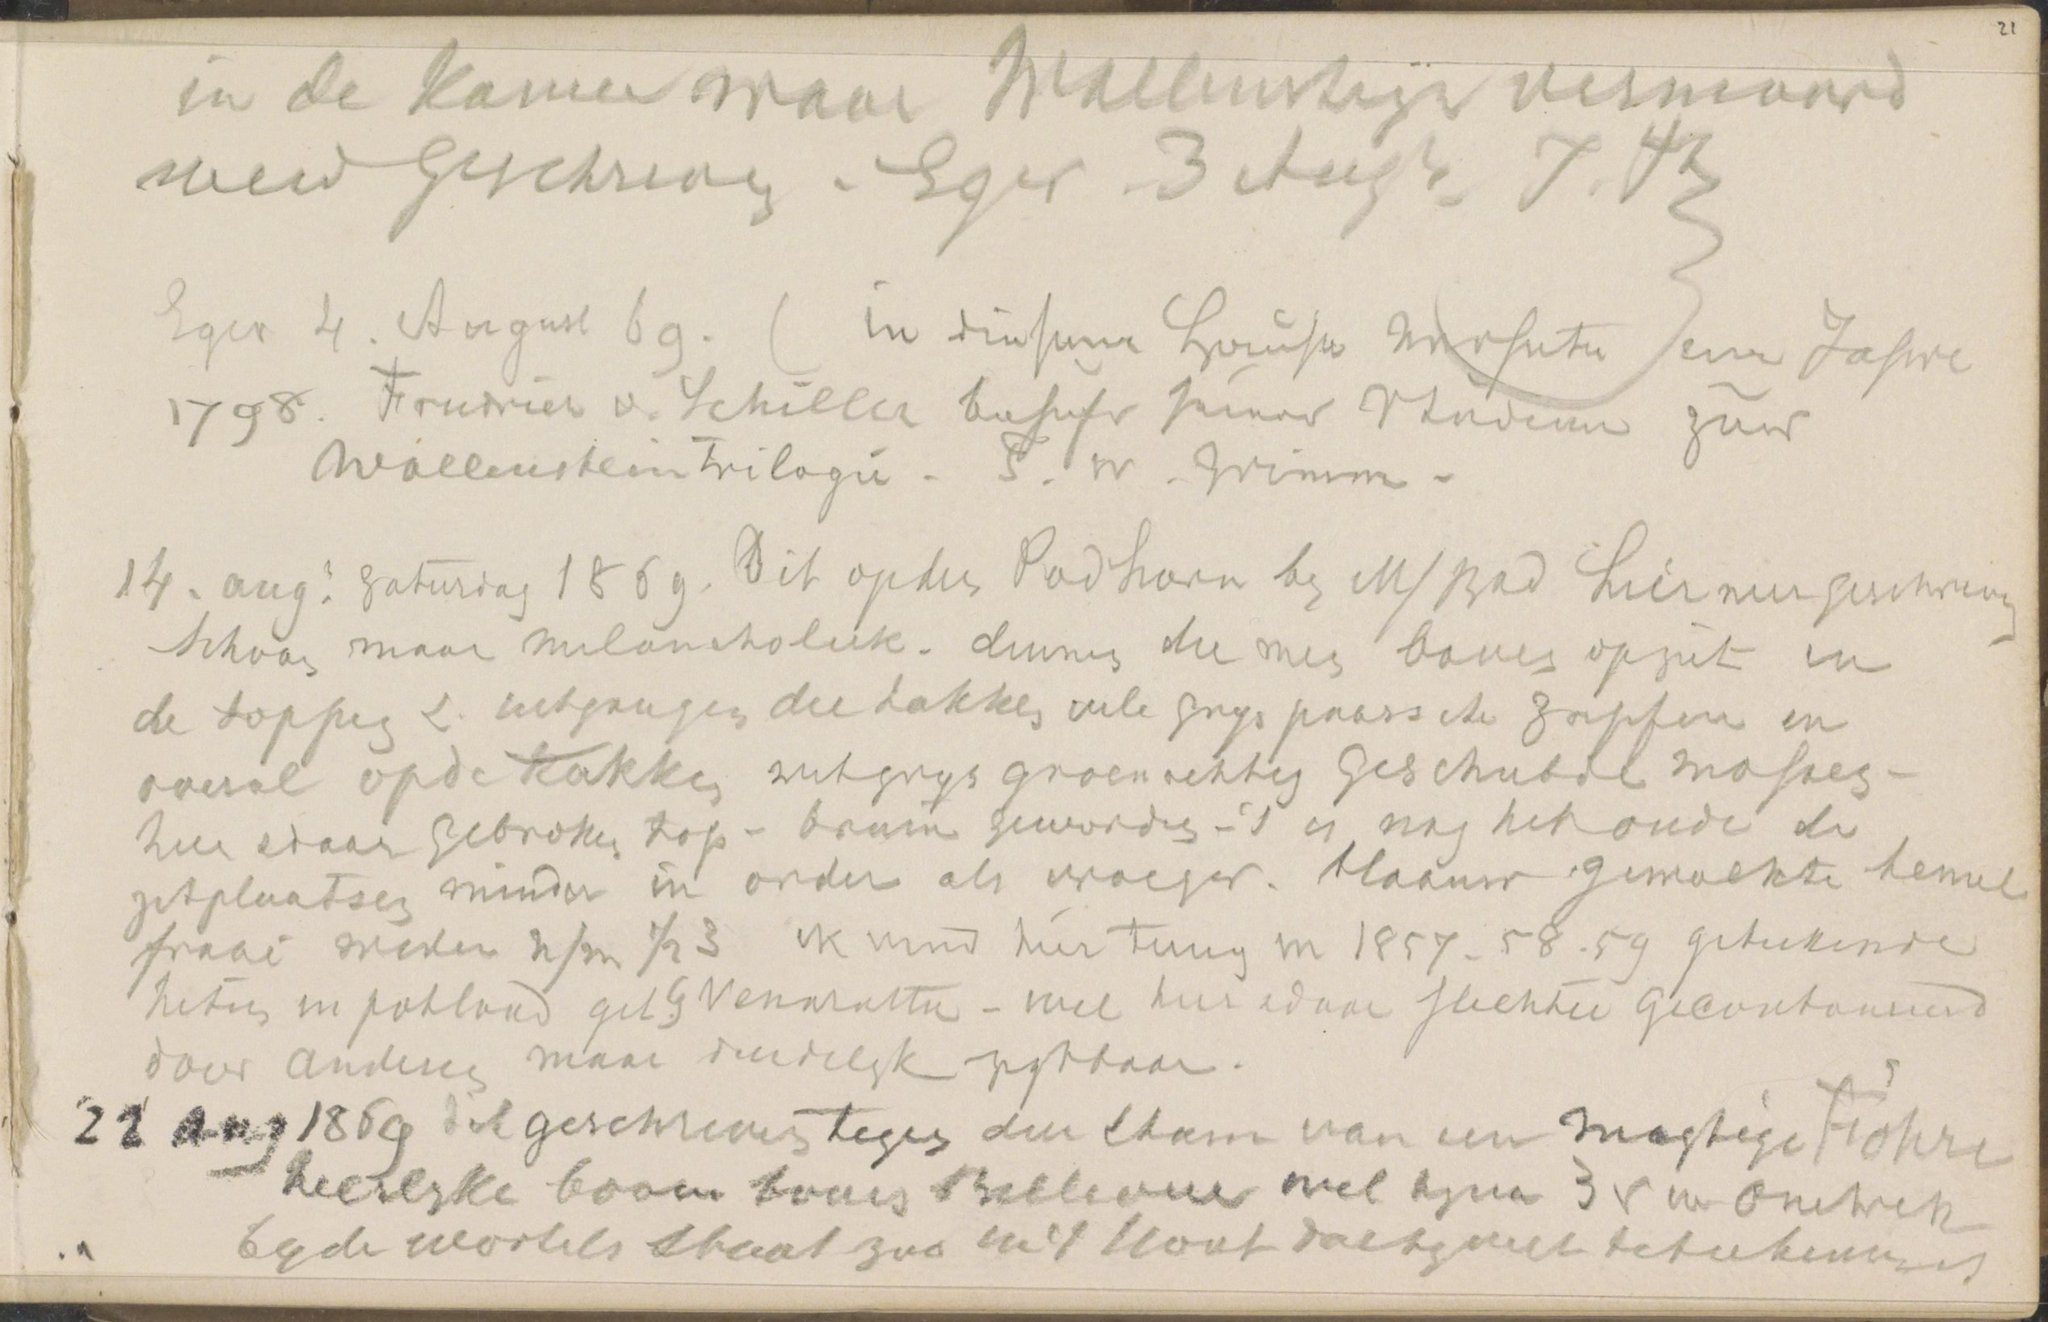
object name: sketchbook leaf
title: Reisnotities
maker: johannes tavenraat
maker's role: draughtsman, painter, print maker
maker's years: 1809-1881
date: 1808-1869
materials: paper, pencil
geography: marienbad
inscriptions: date and inscription: ‘[...]’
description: Blad 21 recto uit een schetsboek met 48 bladen.